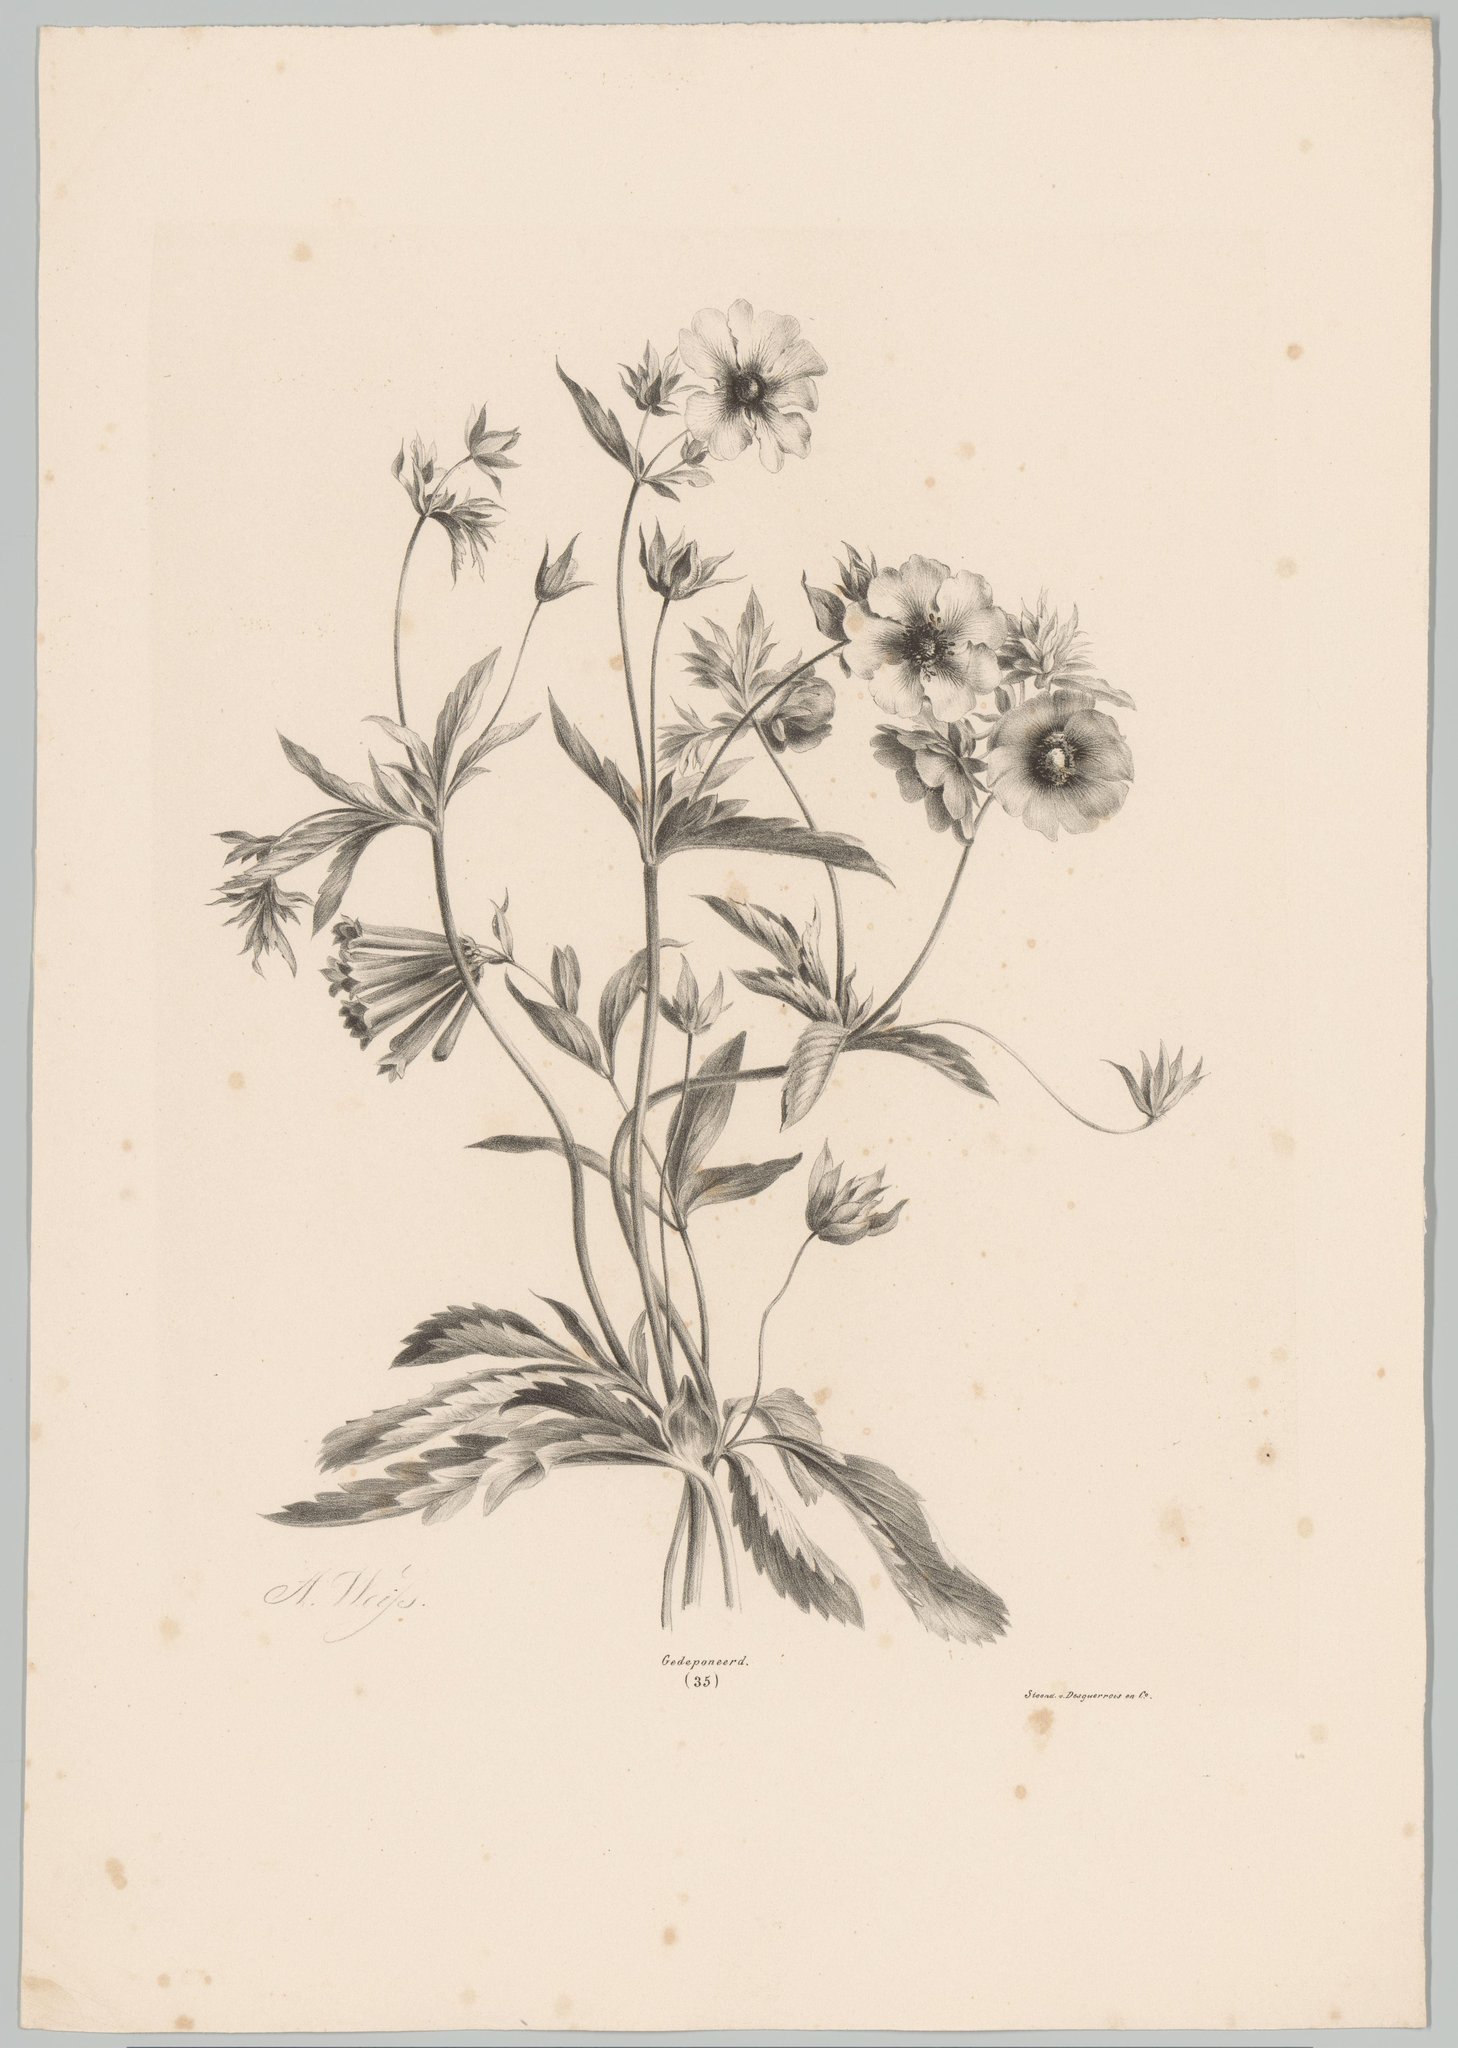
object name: print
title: Bloem en Fruit Studien (...) 10e aflevering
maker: anton weiss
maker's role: draughtsman, print maker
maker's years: 1801-1851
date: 1836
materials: paper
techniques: lithograph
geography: amsterdam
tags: flowers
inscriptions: collector's mark: Lugt 2228, : ‘Gedeponeerd.’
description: Onderdeel van een omslag met een serie van eenenveertig lithografieën van bloemen en fruit.